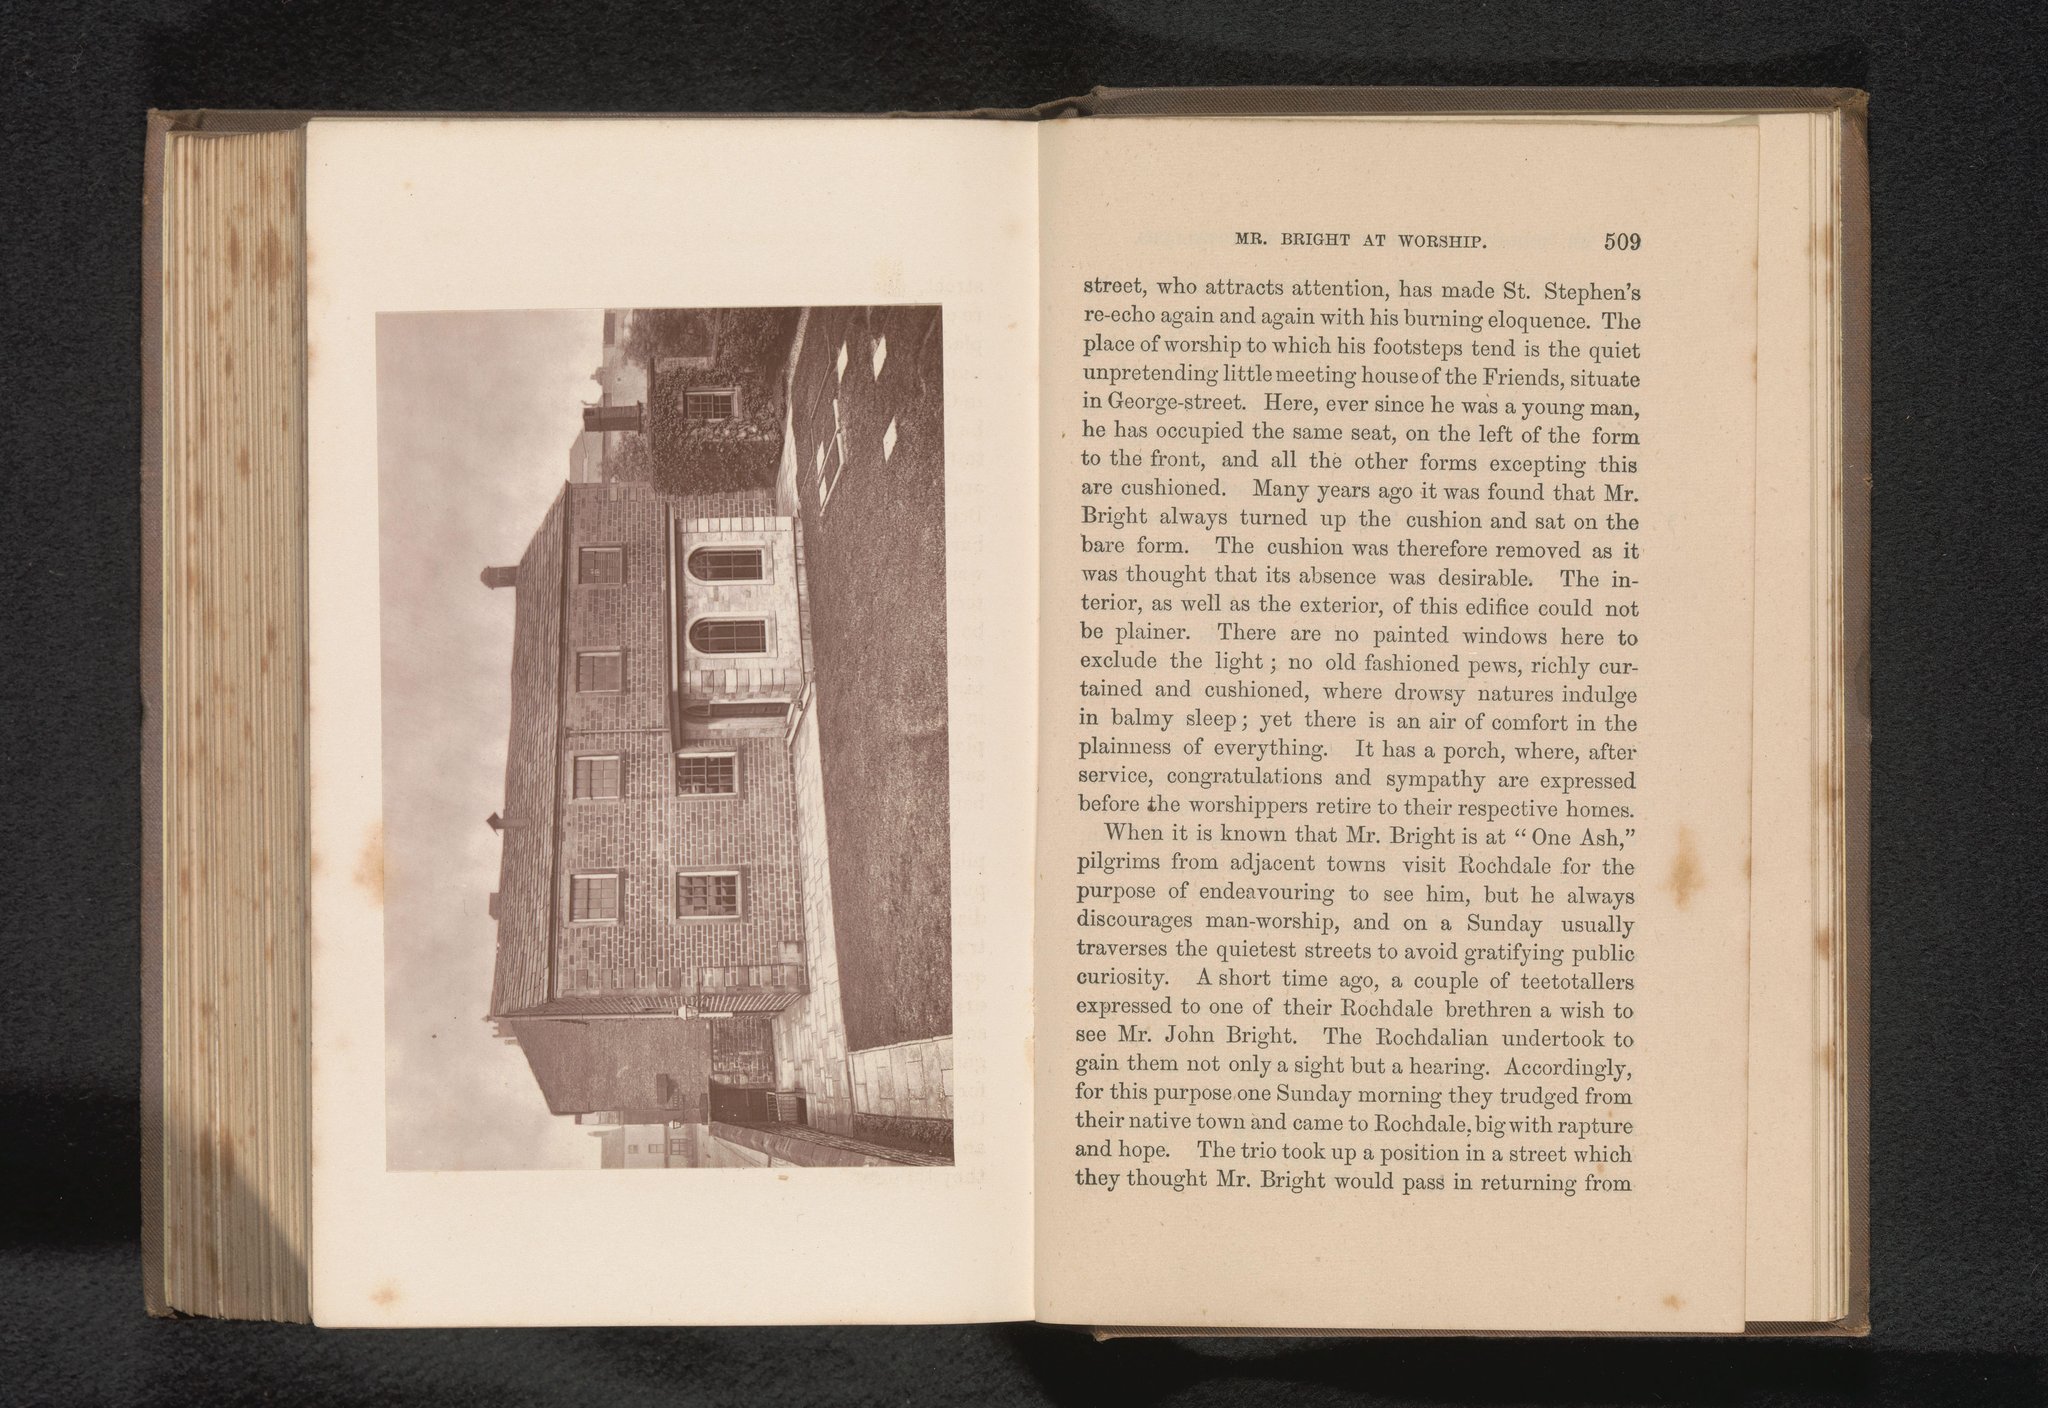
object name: page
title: Exterieur van een woonhuis te Rochdale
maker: Anonymous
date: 1873-1878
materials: paper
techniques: woodburytype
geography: rochdale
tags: housing, façade (of house or building)